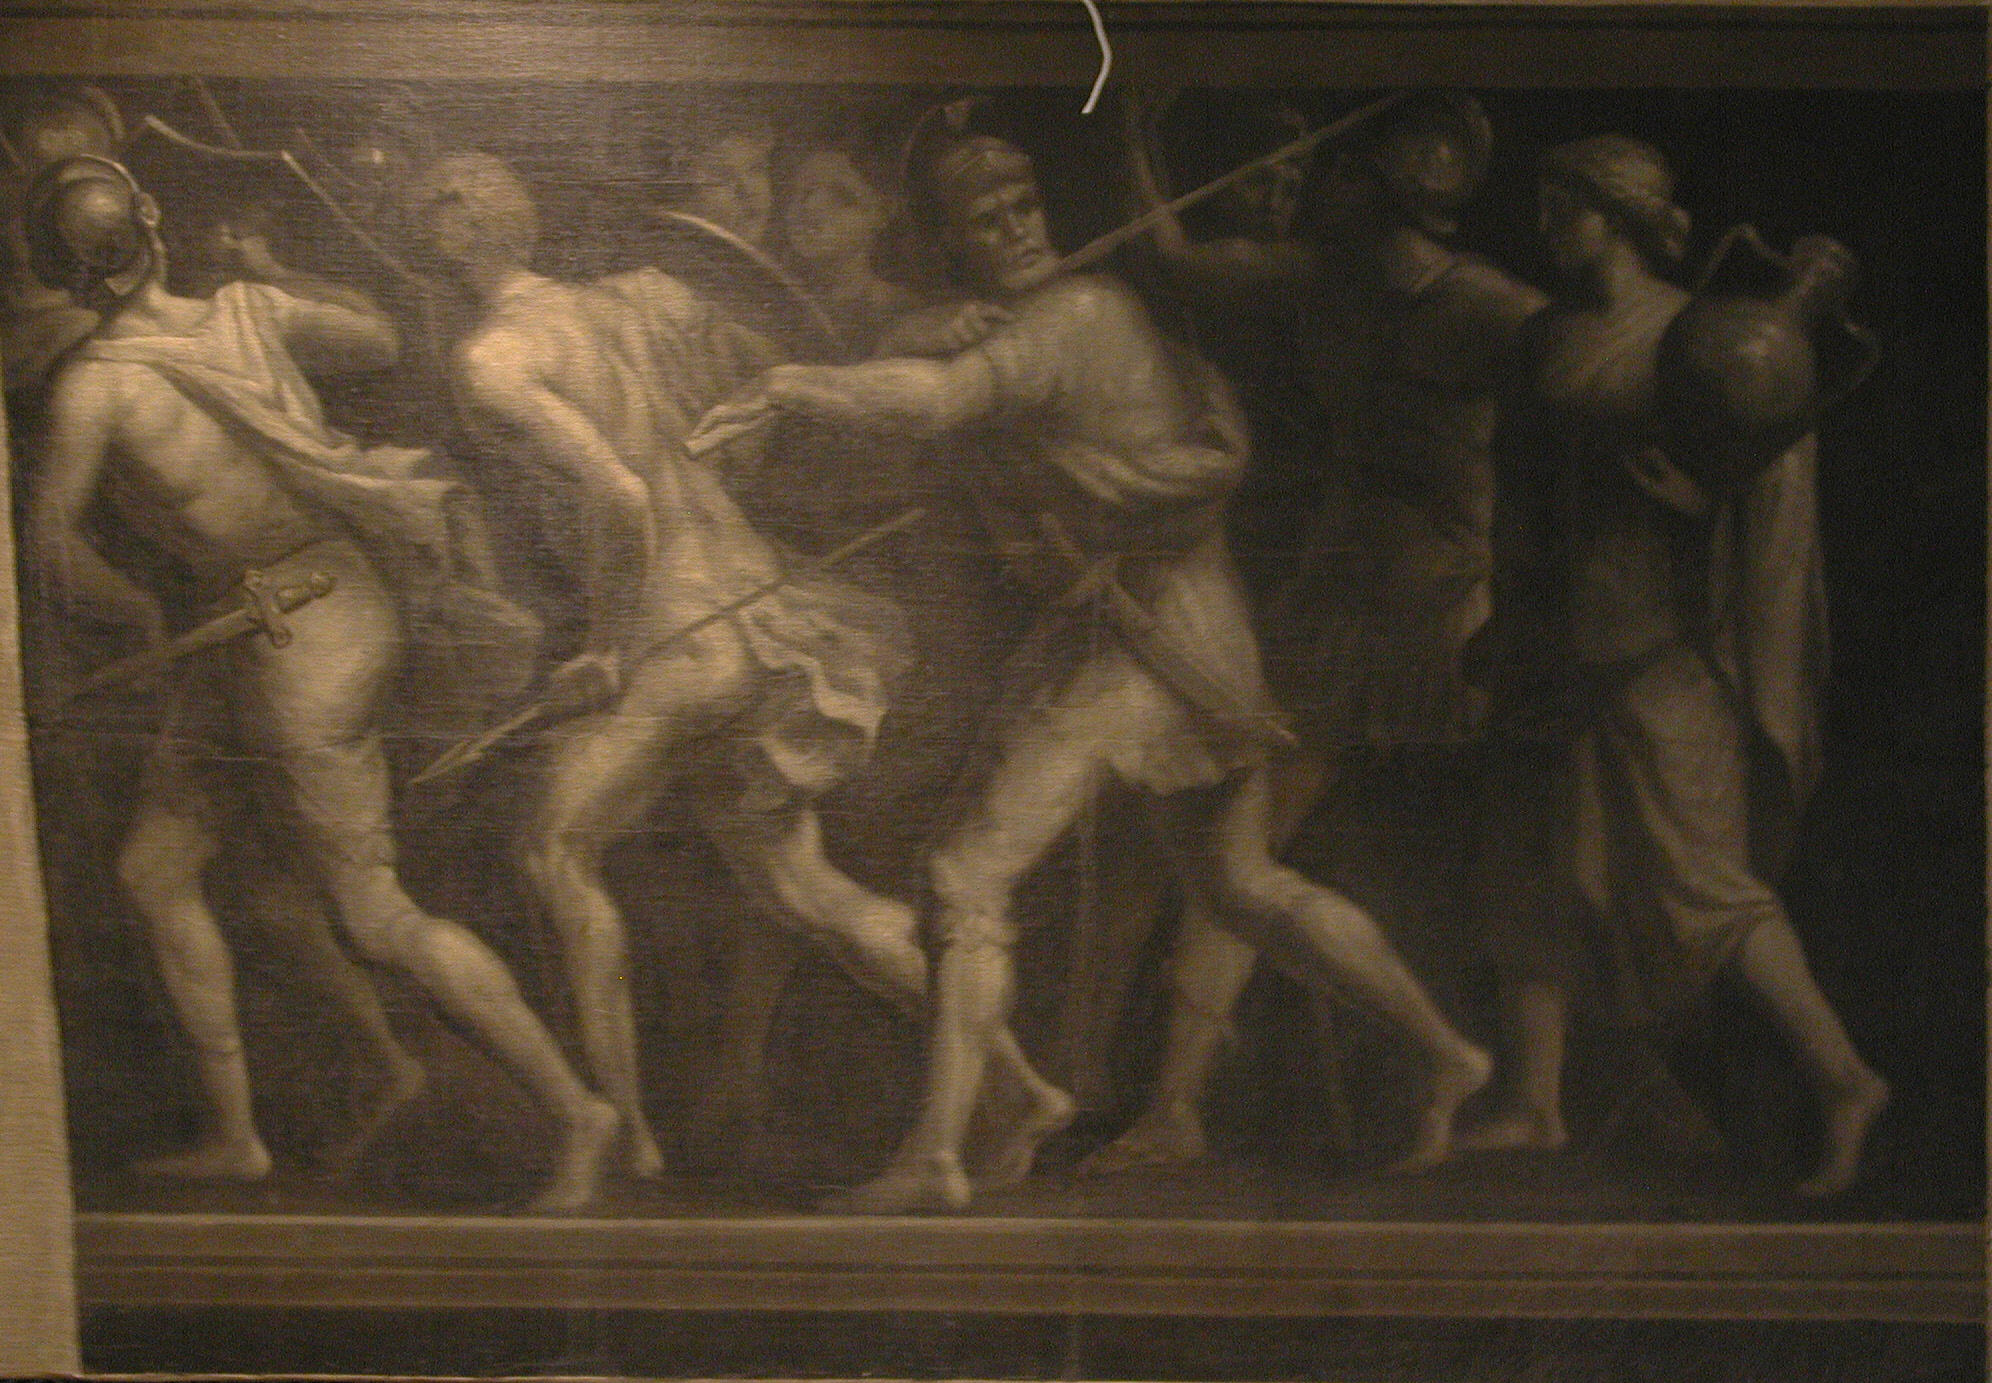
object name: frieze part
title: Frieze fragment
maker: polidoro da caravaggio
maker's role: artist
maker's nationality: italian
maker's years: 1494-1548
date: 1520-1535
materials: canvas, oil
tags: men,women